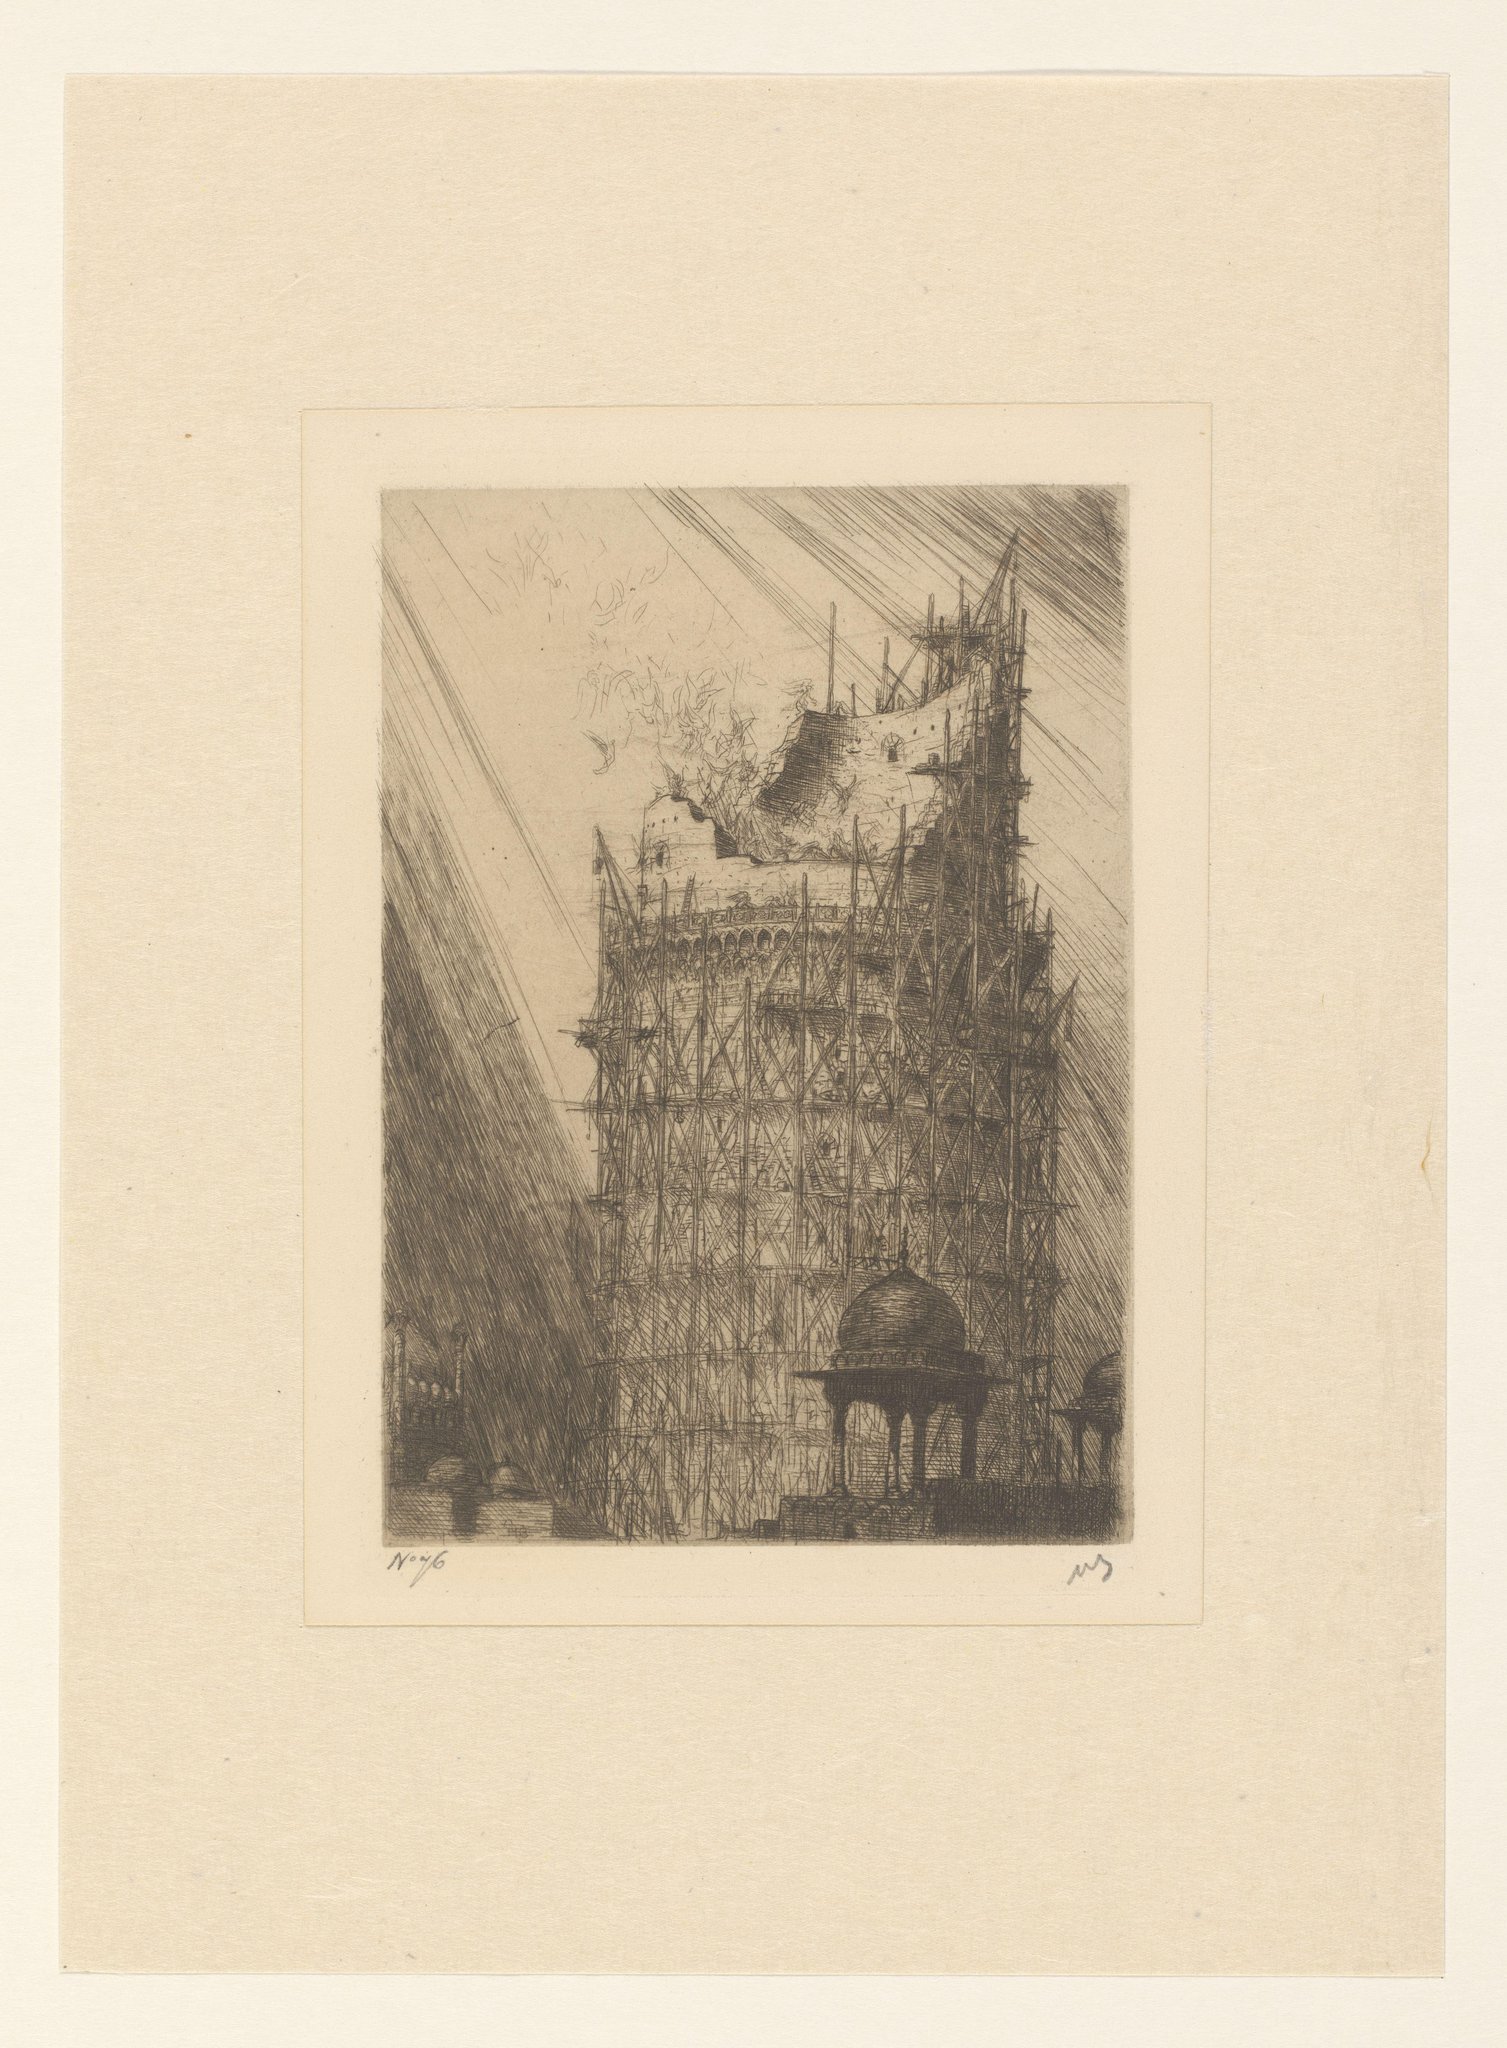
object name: print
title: Betoverde toren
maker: marius bauer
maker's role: draughtsman, print maker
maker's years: 1867-1932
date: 1898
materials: paper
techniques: etching, intaglio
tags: tower, clock tower ~ monumental adornment, fabulous beings with wings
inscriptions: collector's mark: Lugt 2228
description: Een toren in aanbouw. Bij de bovenste verdiepingen enkele gevleugelde figuren.